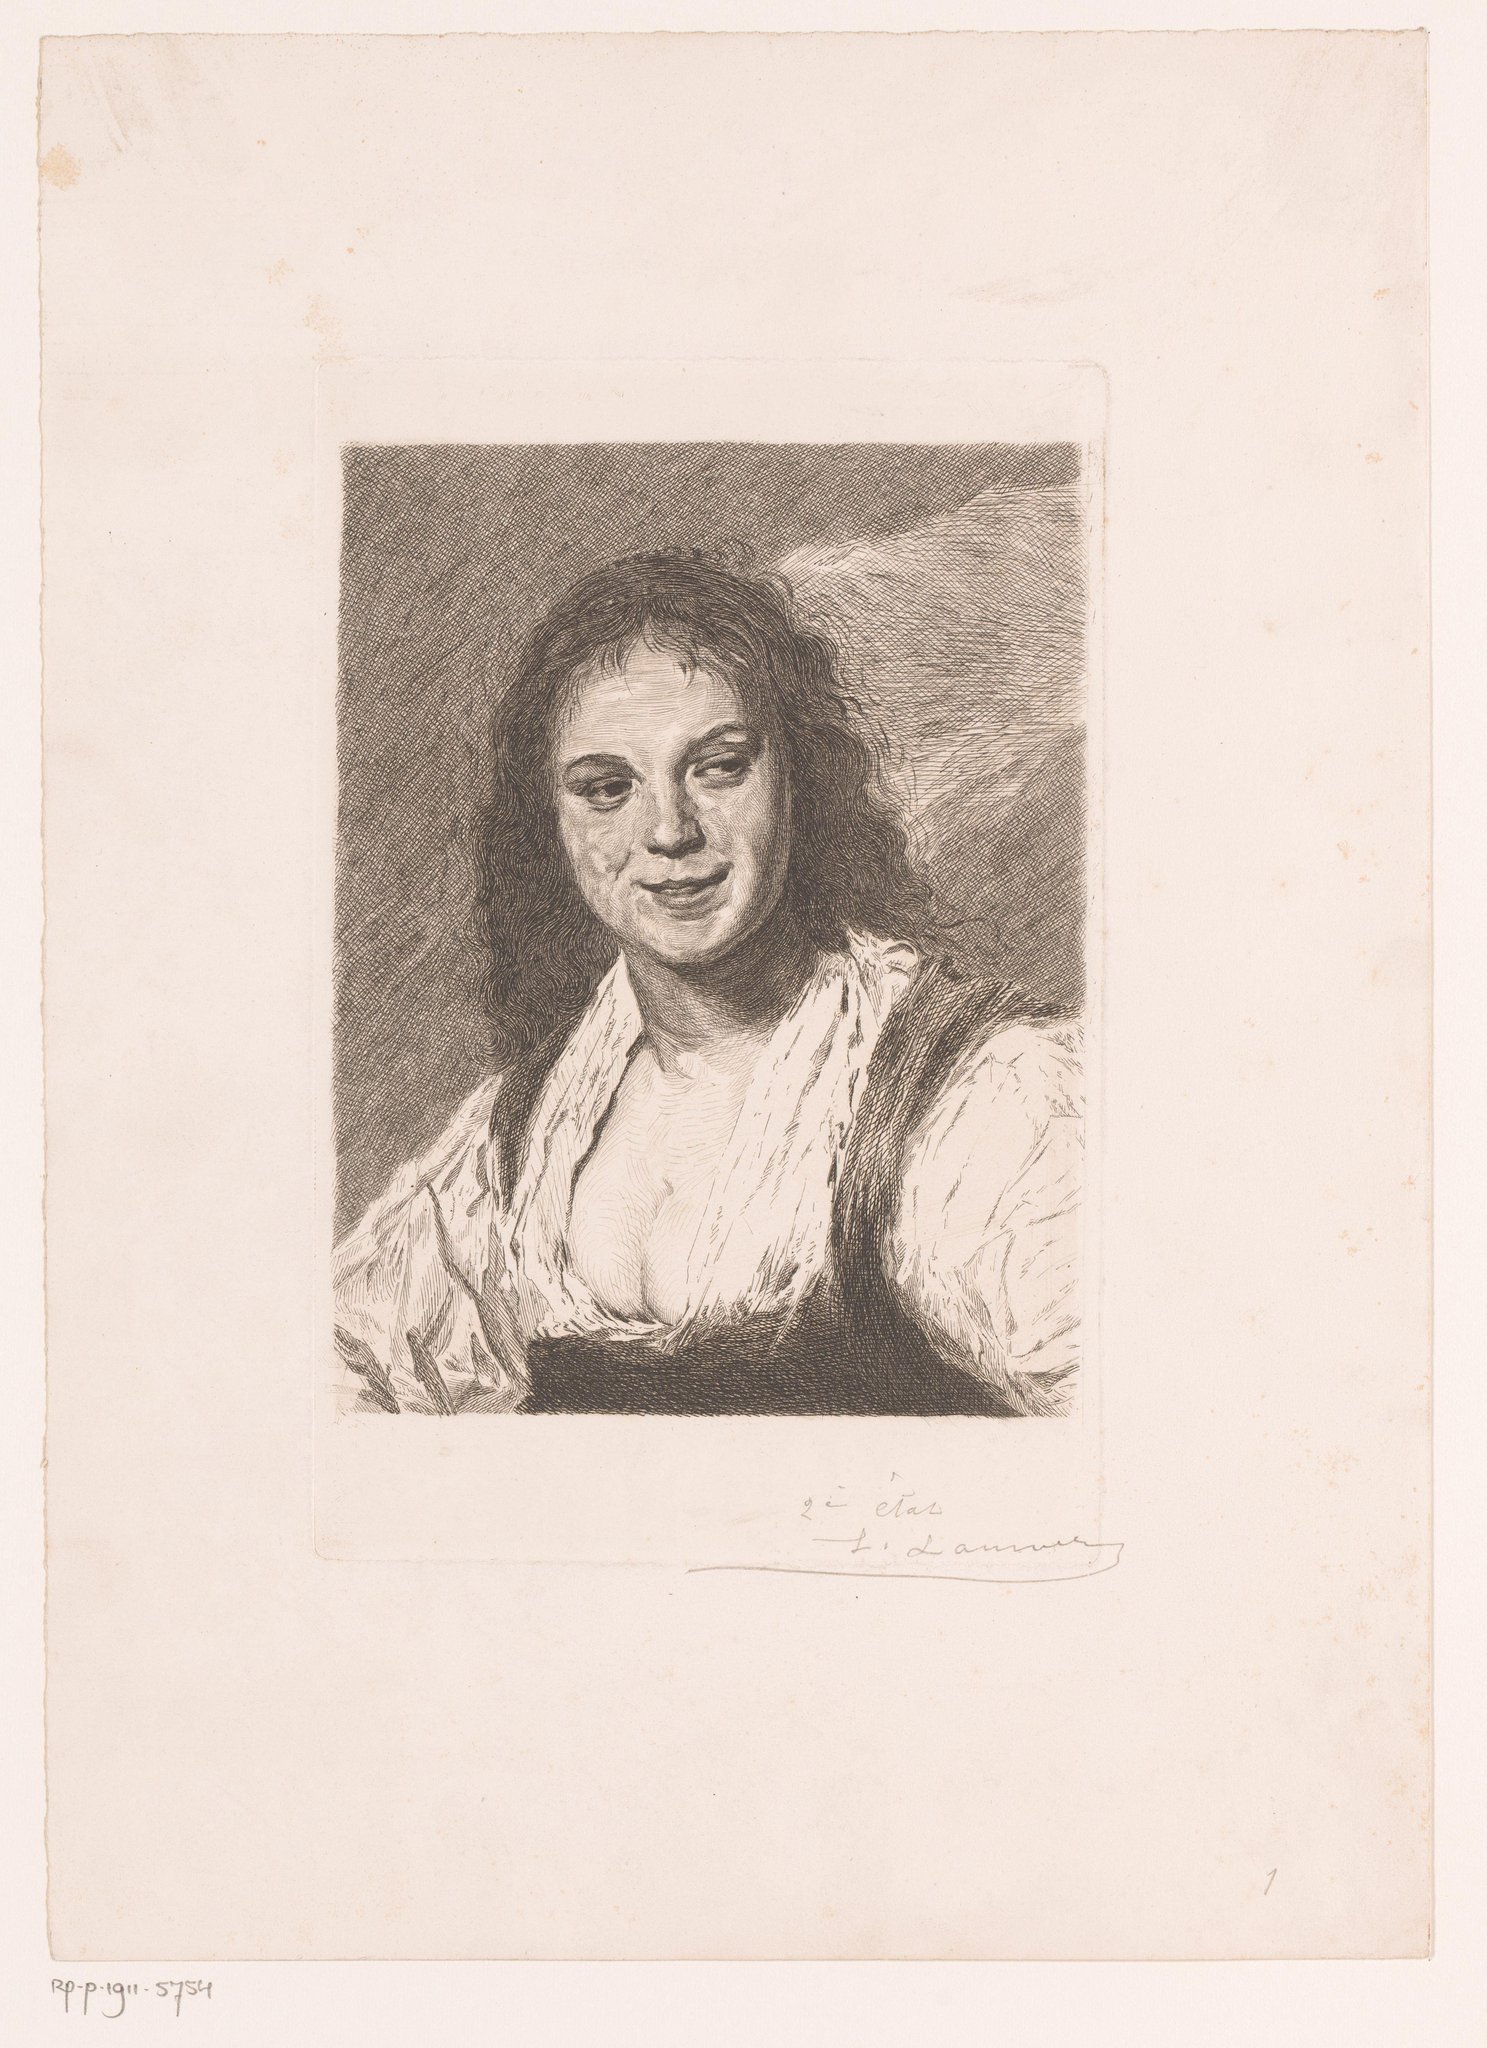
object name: print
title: Portret van een onbekend Roma meisje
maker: frans lauwers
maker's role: print maker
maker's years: 1854-1931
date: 1864-1911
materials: paper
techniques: etching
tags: adolescent, young woman, maiden, wandering communities: romani or roma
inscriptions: collector's mark: Lugt 2228, annotation: ‘2èm état’